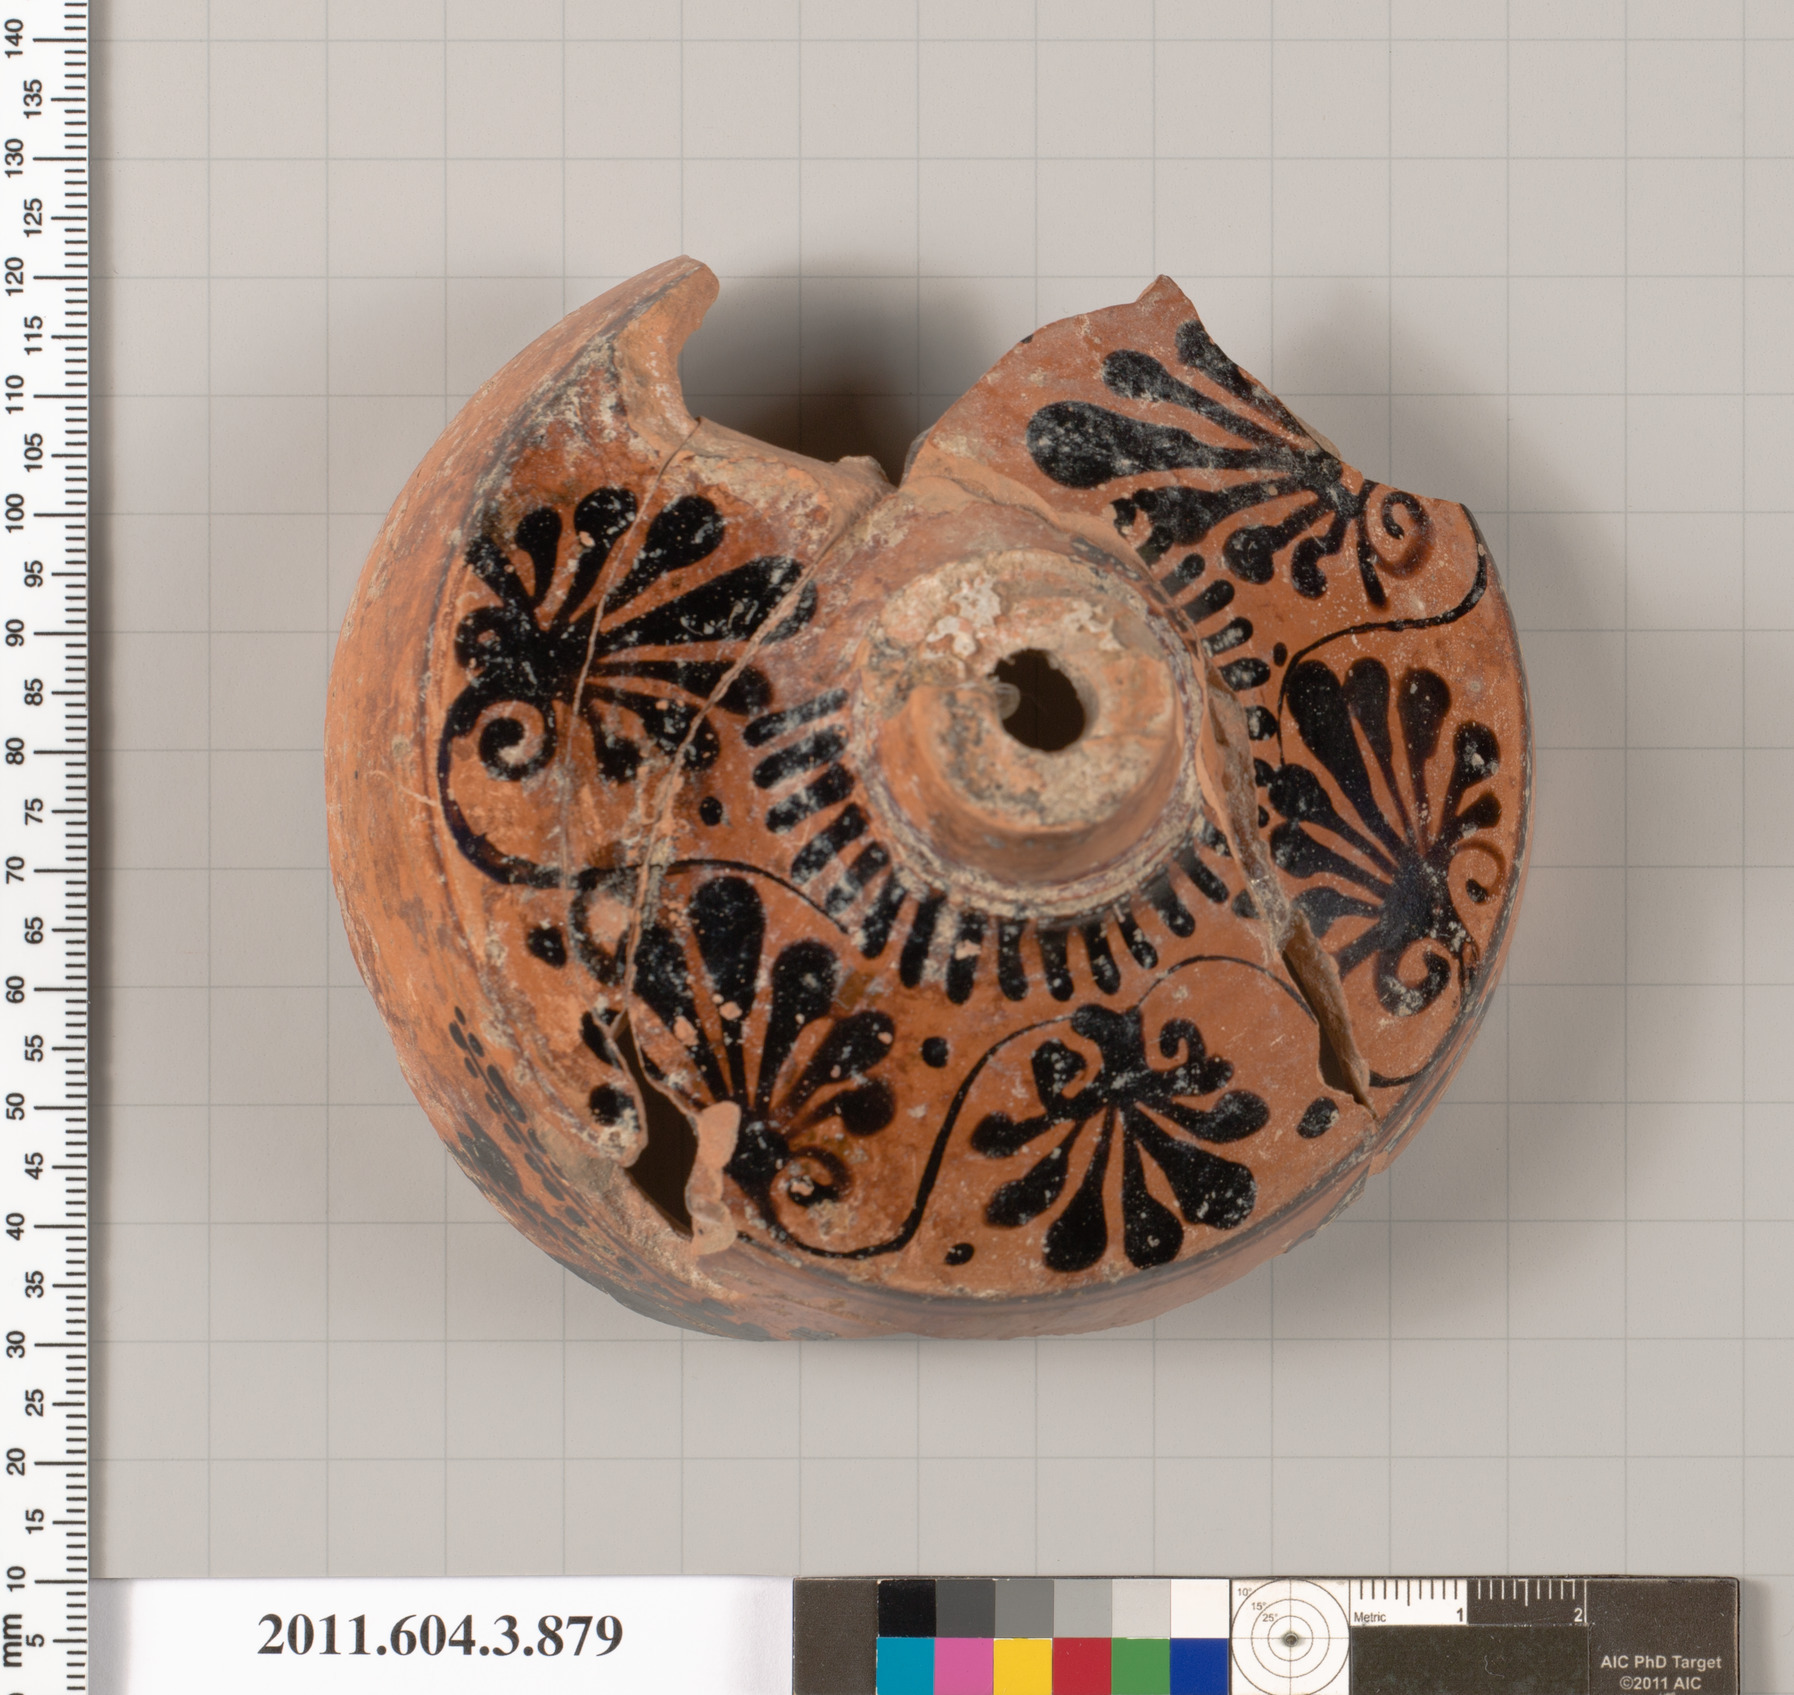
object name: lekythos fragment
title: Terracotta fragment of a lekythos (oil flask)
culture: greek, attic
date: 534-468 BCE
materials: terracotta